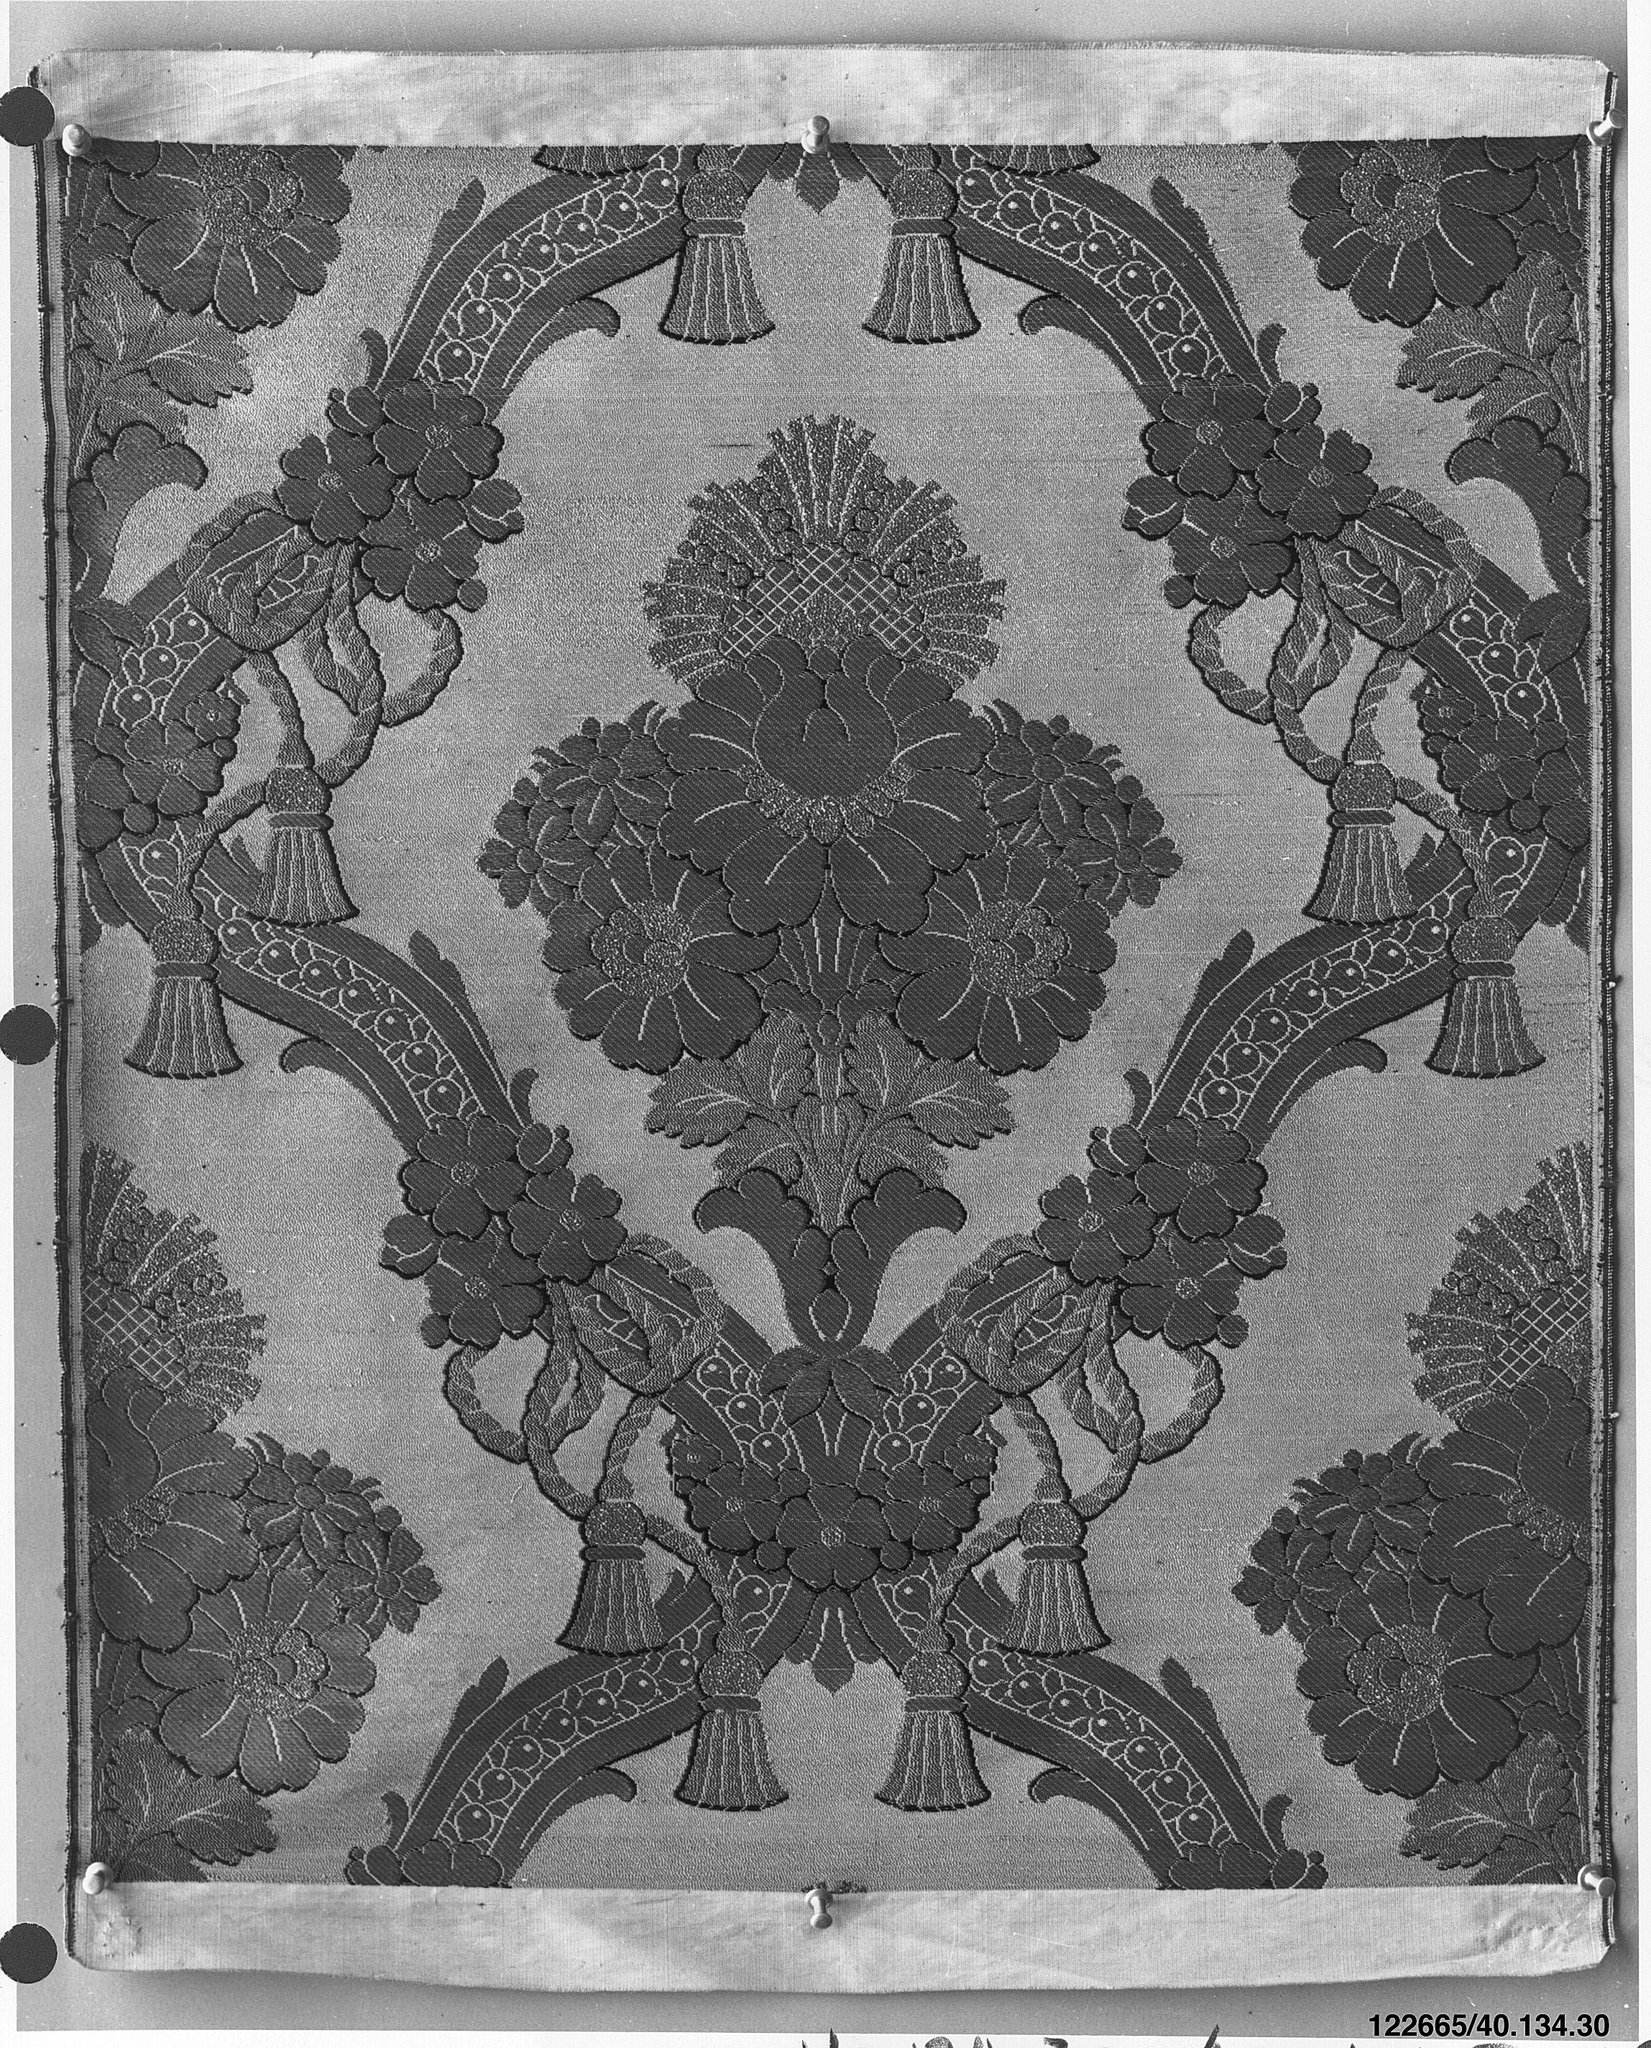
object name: piece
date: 1701-1900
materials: metal thread, silk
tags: flowers